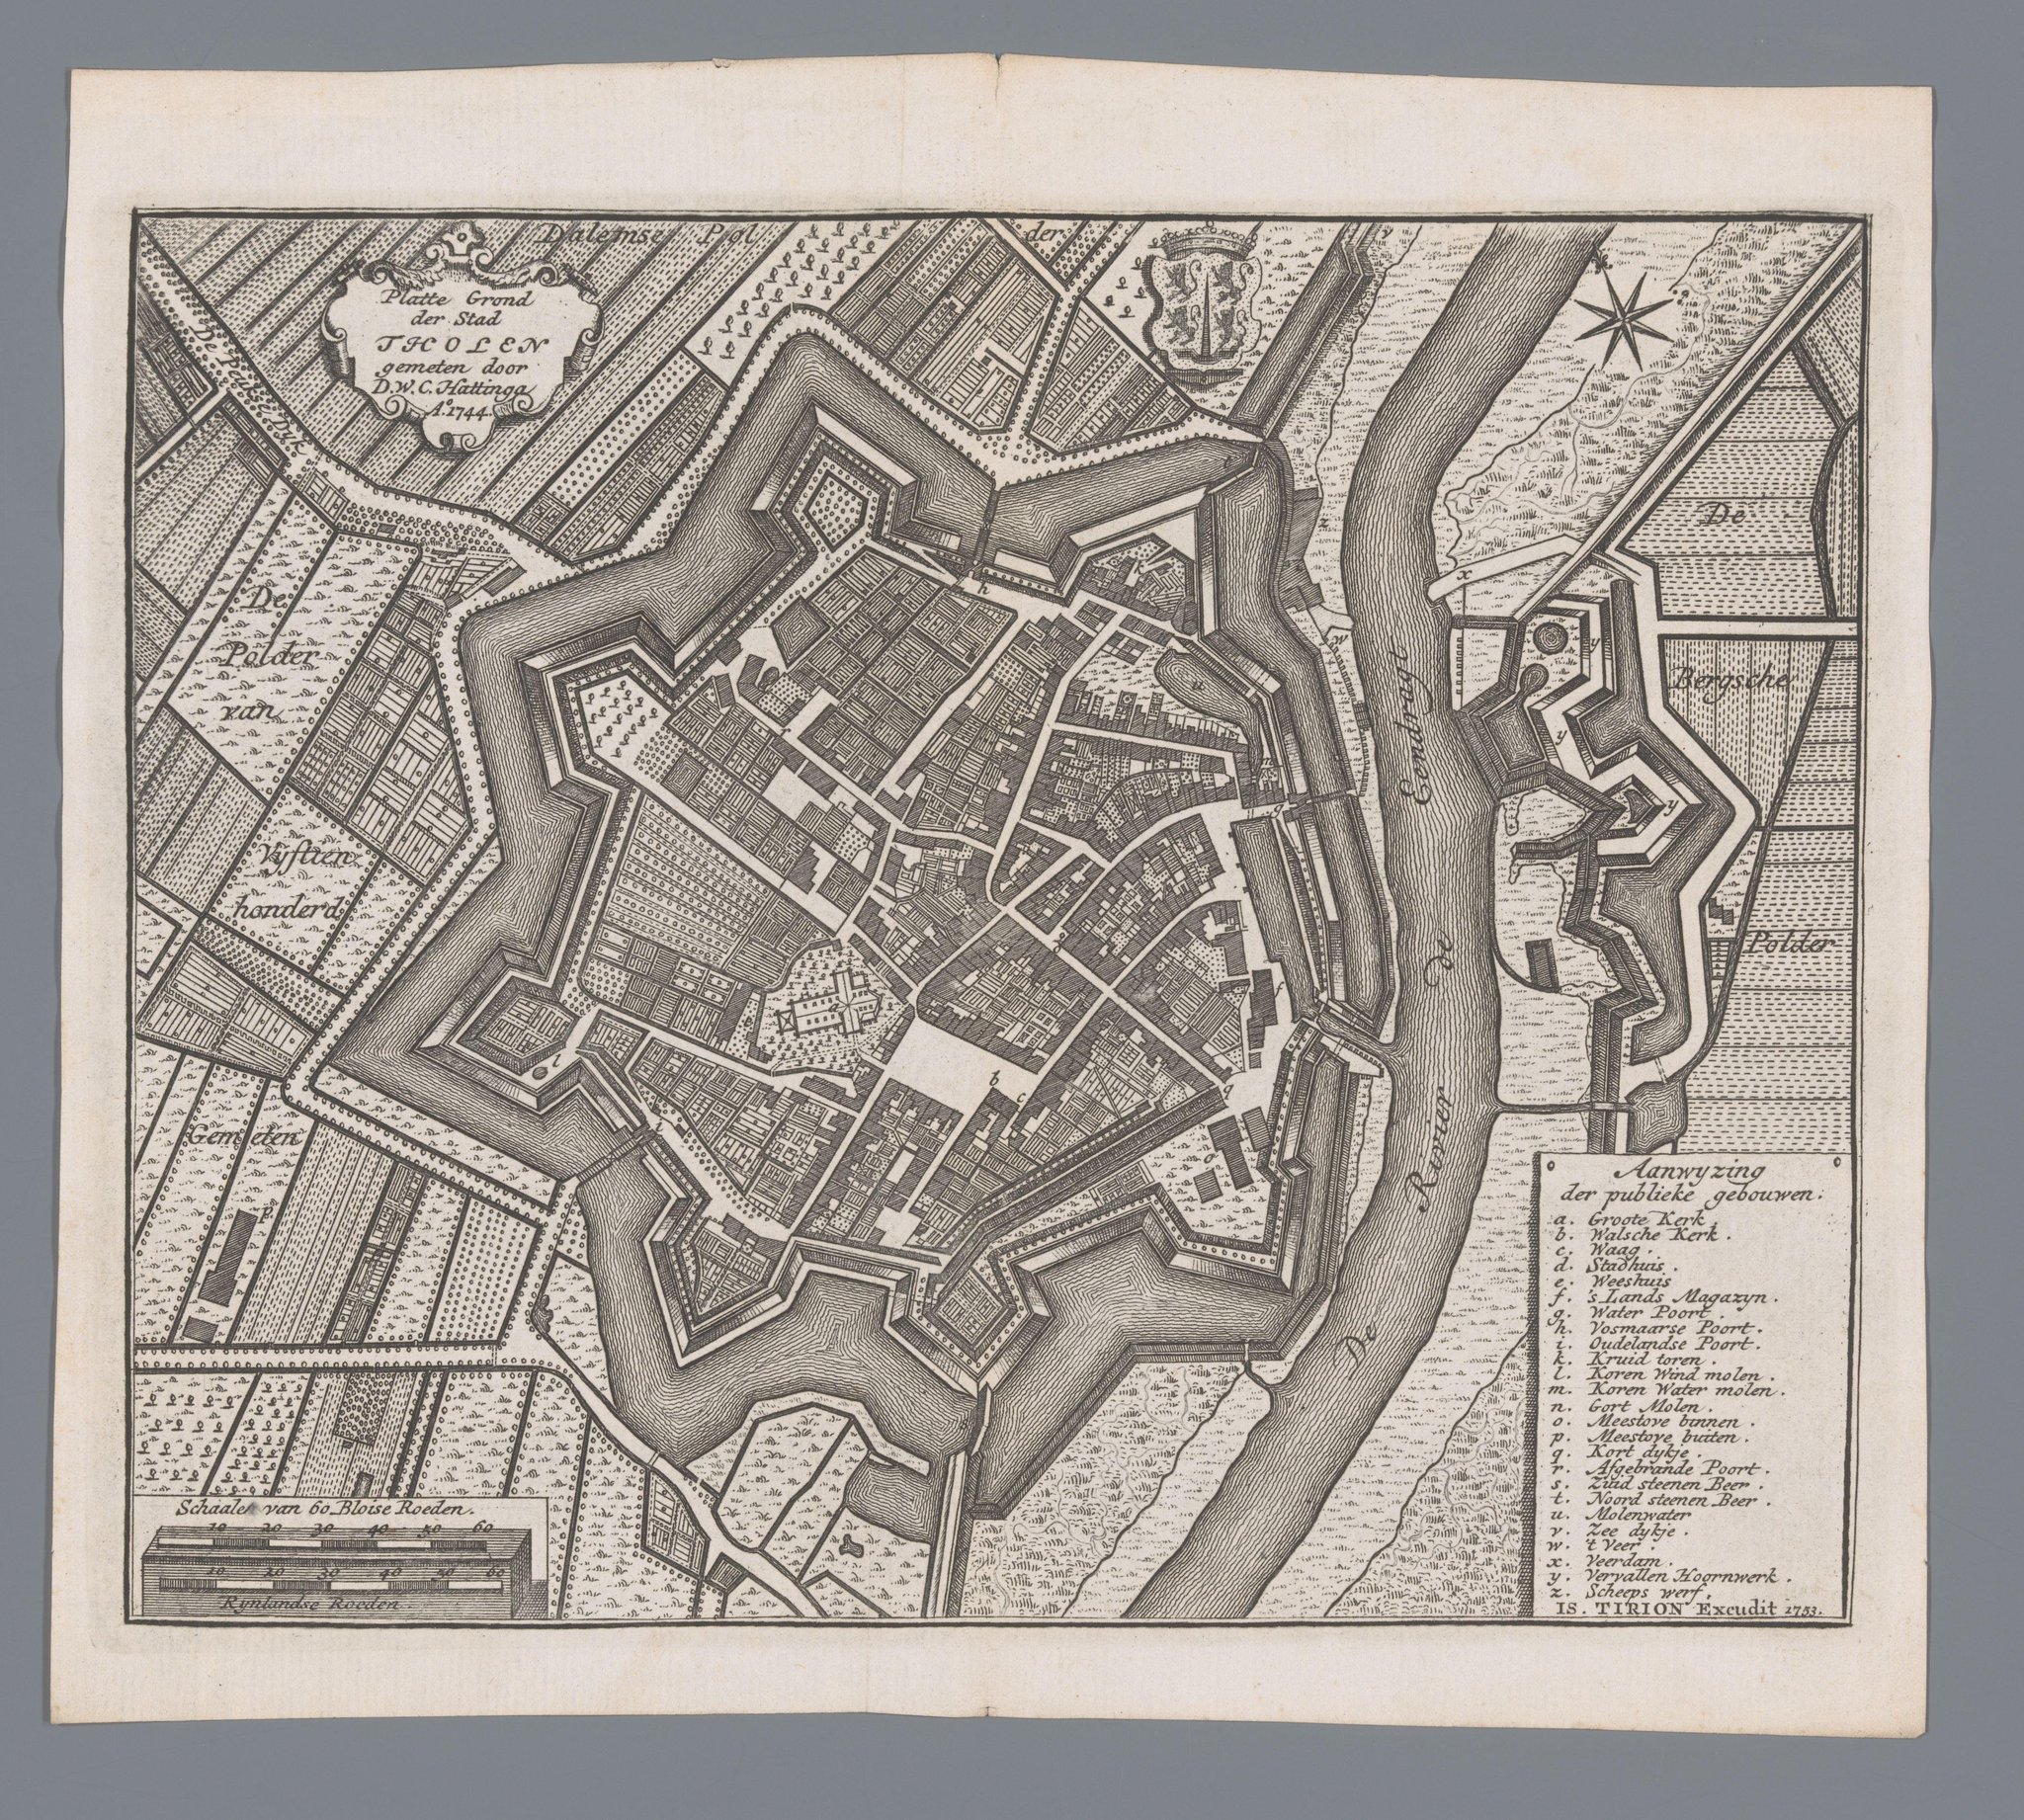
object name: print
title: Plattegrond der Stad Tholen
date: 1753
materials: paper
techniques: etching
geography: amsterdam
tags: maps of cities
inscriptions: collector's mark: Lugt 2228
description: Prent uit: Wagenaar, Jan. Tegenwoordige staat der Vereenigde Nederlanden (...). Amsterdam: Isaak Tirion, 1753, dl. 10, tussen p. 66 en 67.